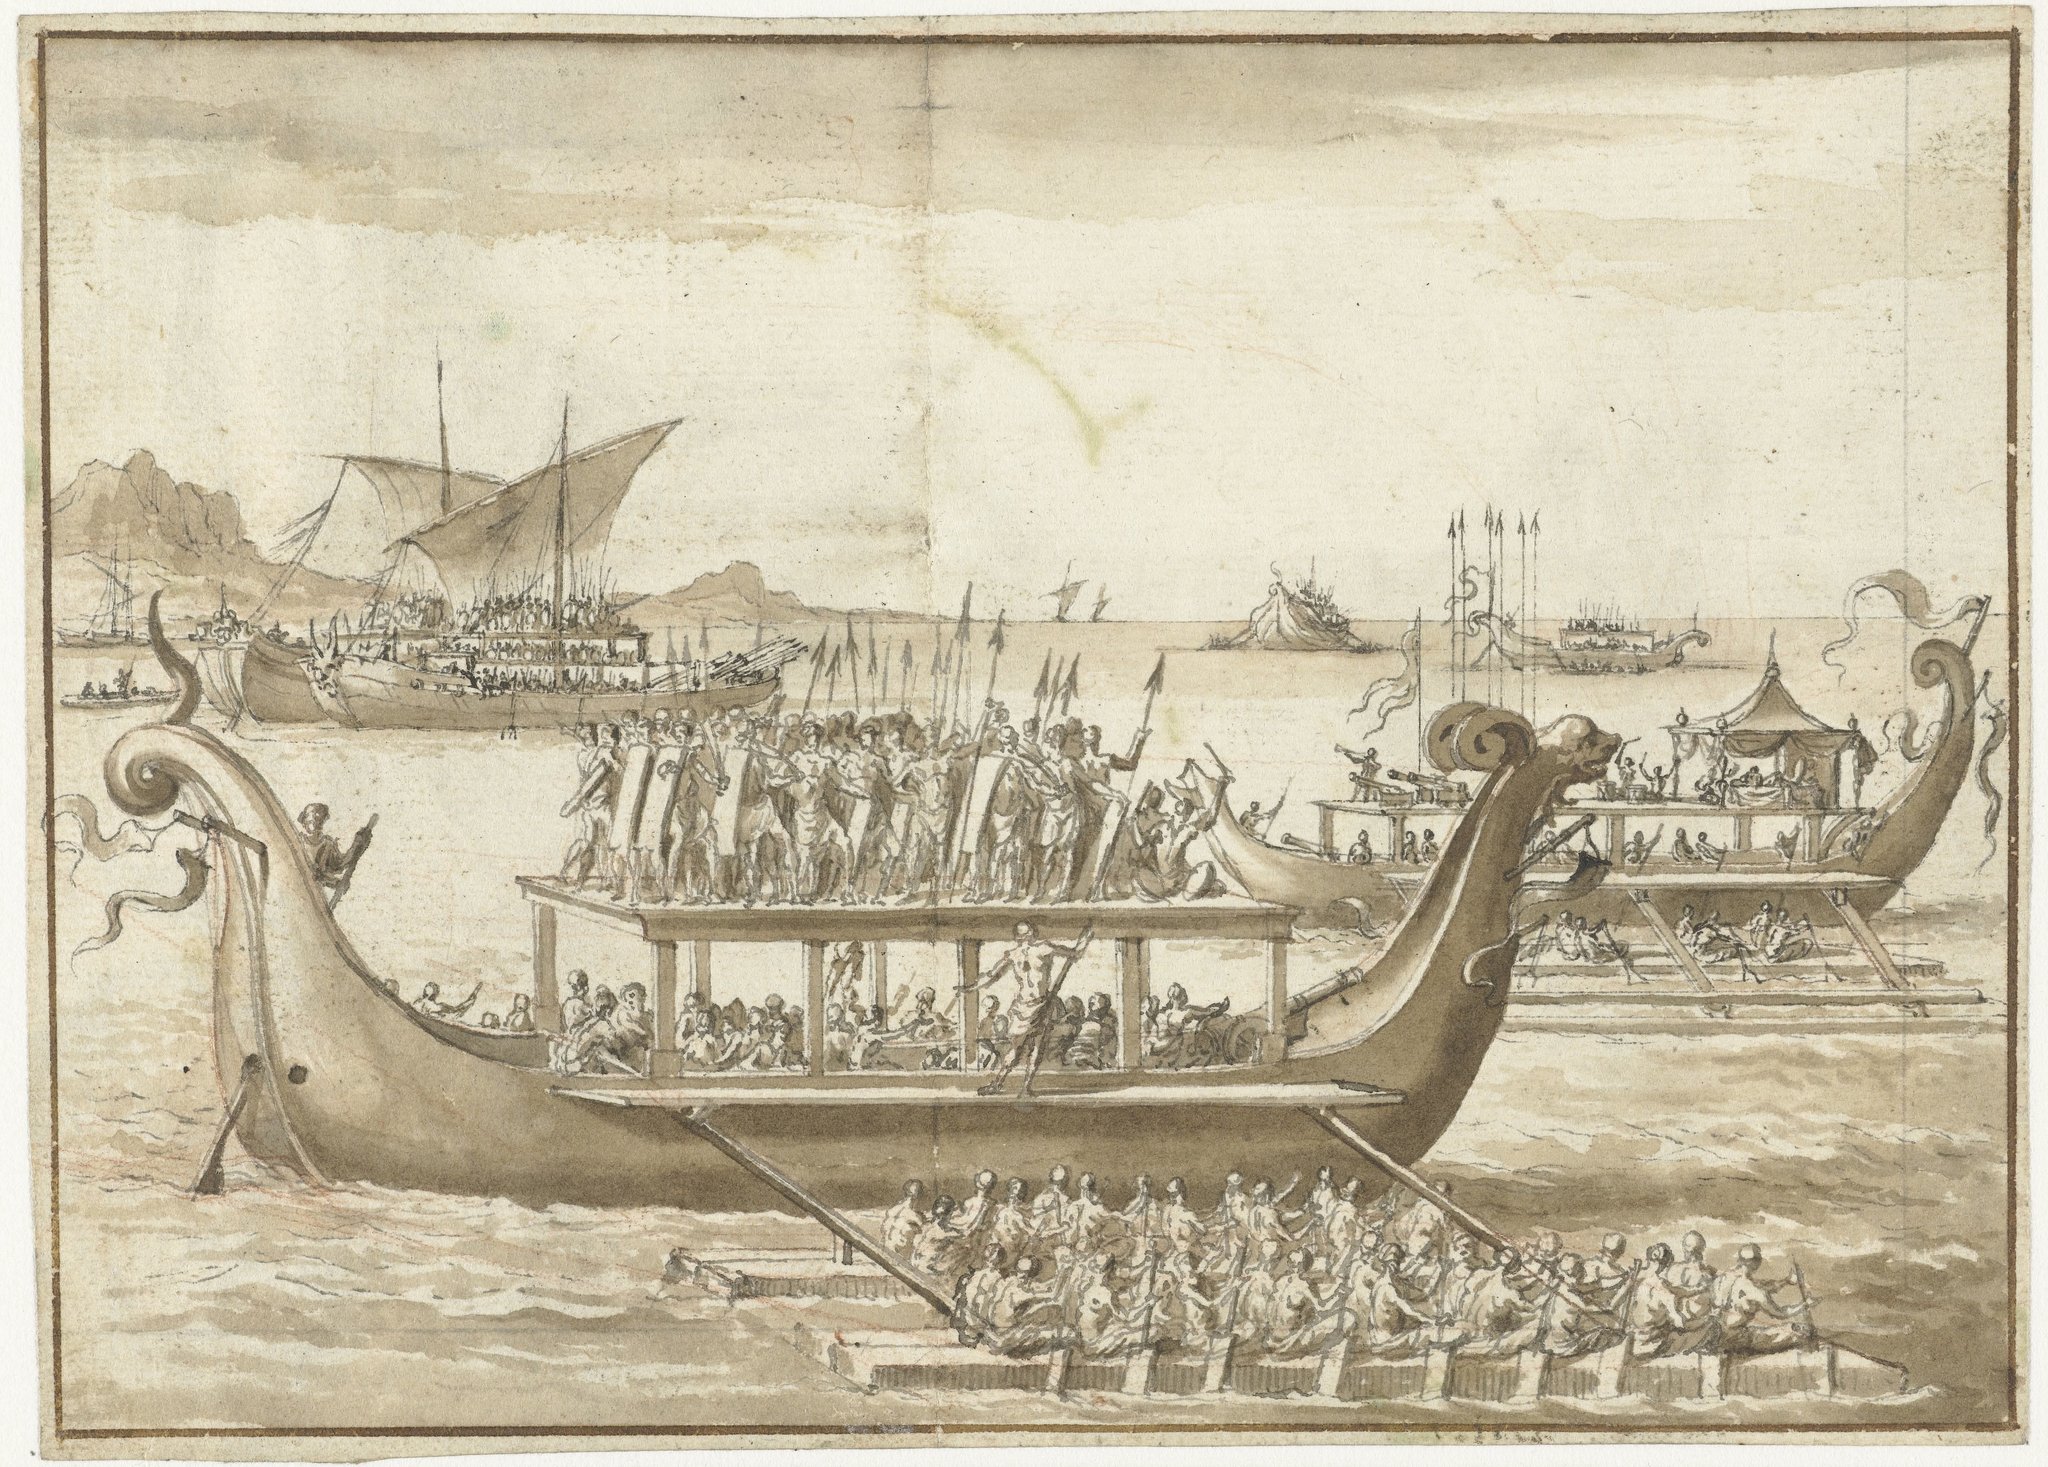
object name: drawing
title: Verschillende galeien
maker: jan goeree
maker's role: draughtsman, print maker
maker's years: 1670-1731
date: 1680-1731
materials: chalk, ink, paper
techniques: brush, pen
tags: rowing-boat, canoe, etc.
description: Verschillende galeien, fantasie of historiserende weergave van een gebeurtenis (zoals een keizerlijk bezoek) uit de Romeinse Tijd of uit de Griekse oudheid. Mogelijk een ontwerp voor een boekillustratie of prent.